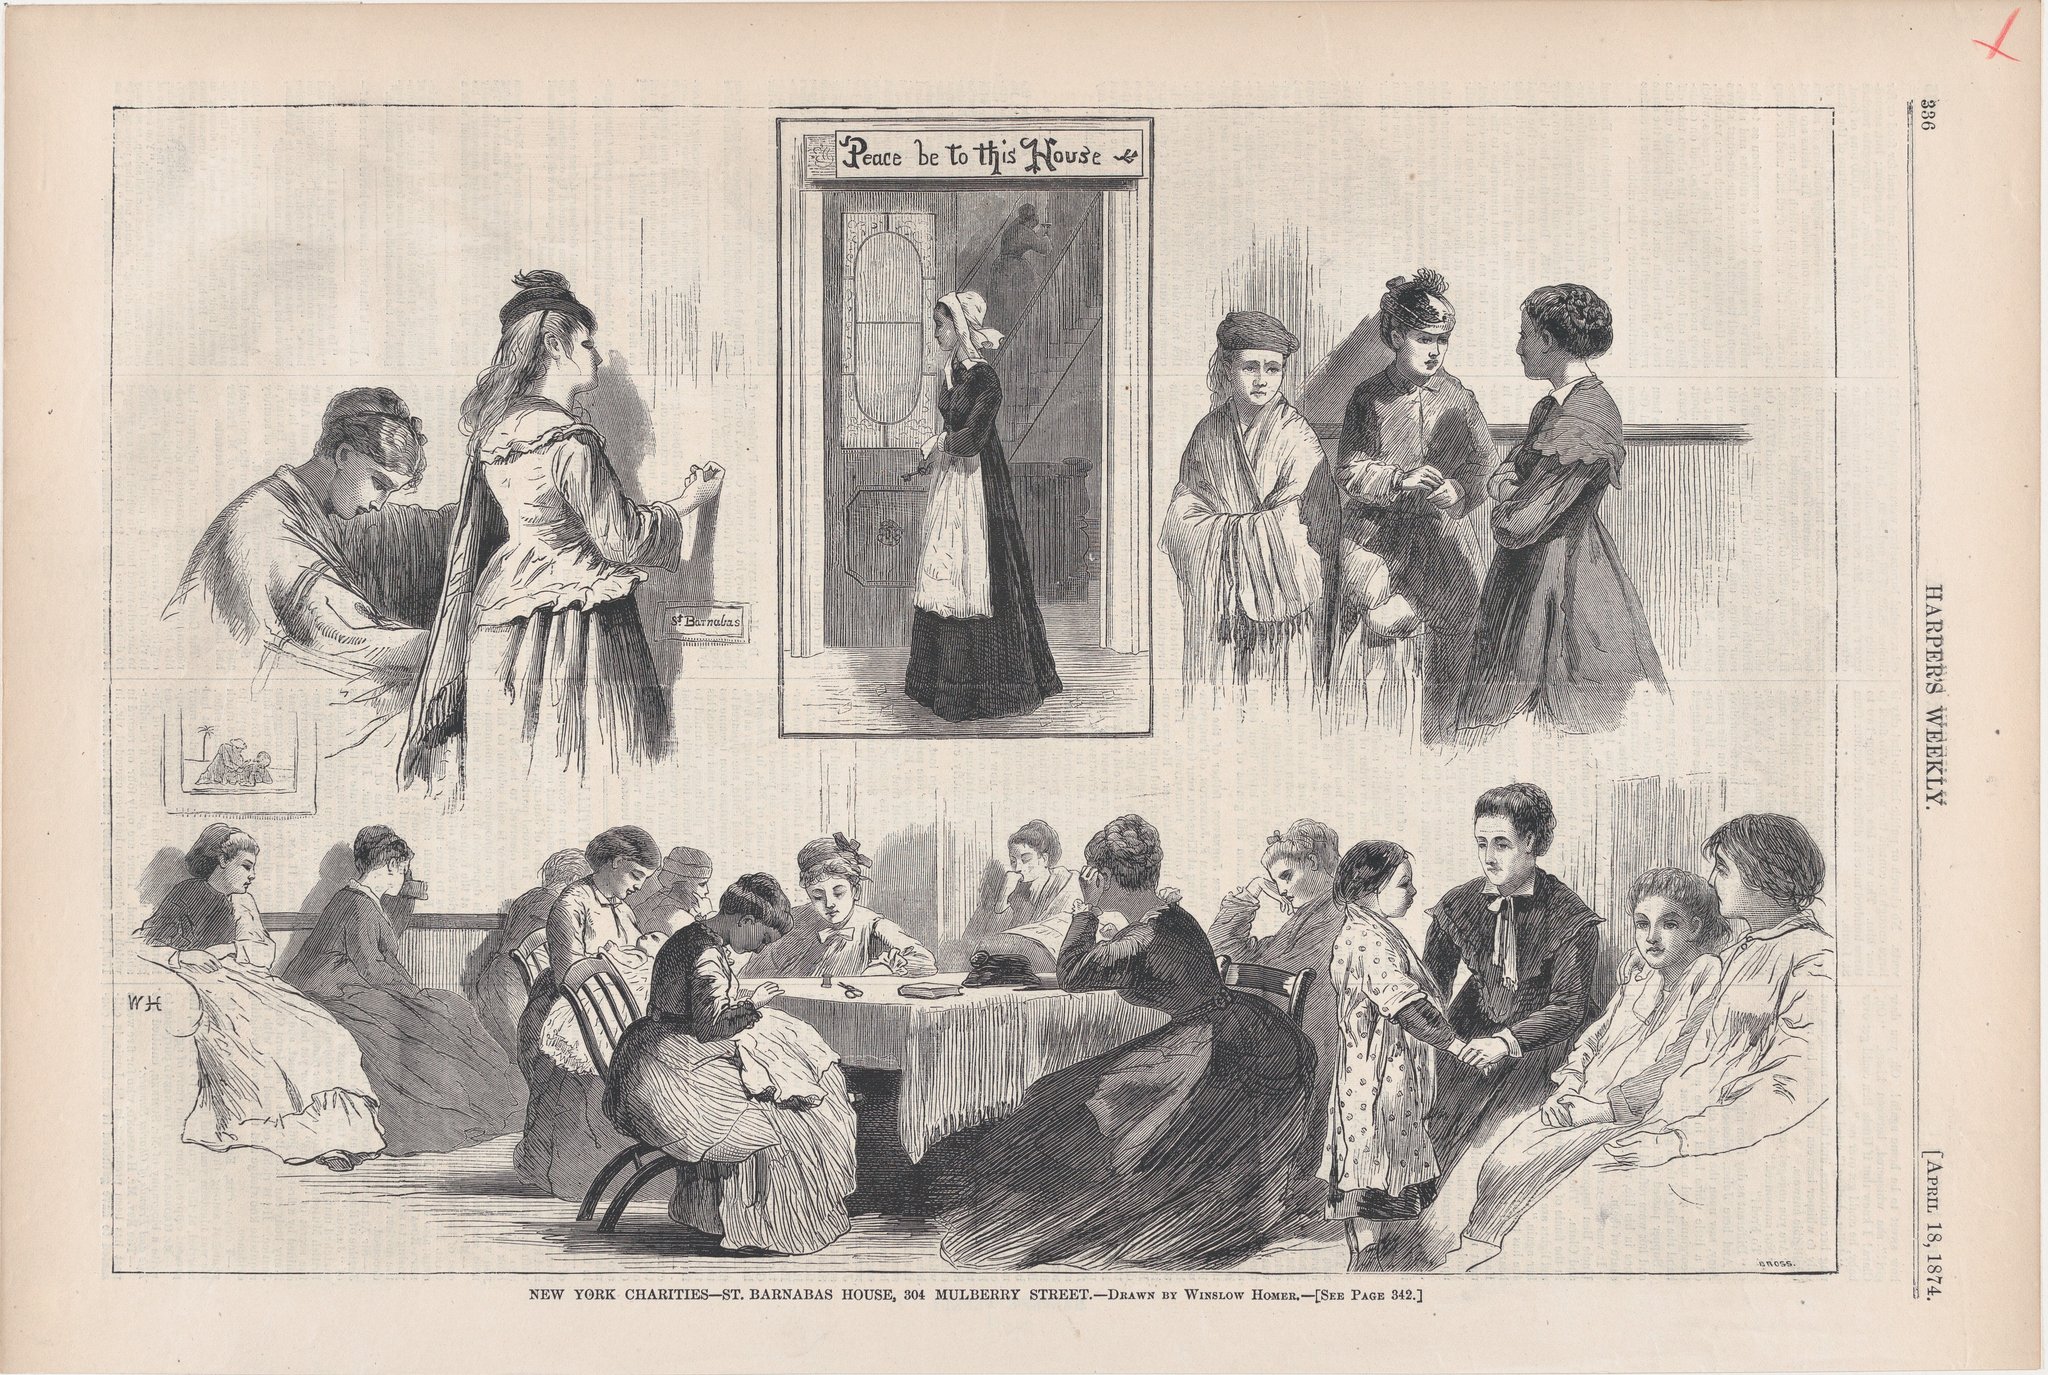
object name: print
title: New York Charities – St. Barnabas House, 304 Mulberry Street (from "Harper's Weekly," Vol. XVIII)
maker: winslow homer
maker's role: artist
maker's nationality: american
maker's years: 1836-1910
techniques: engraving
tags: girls,women